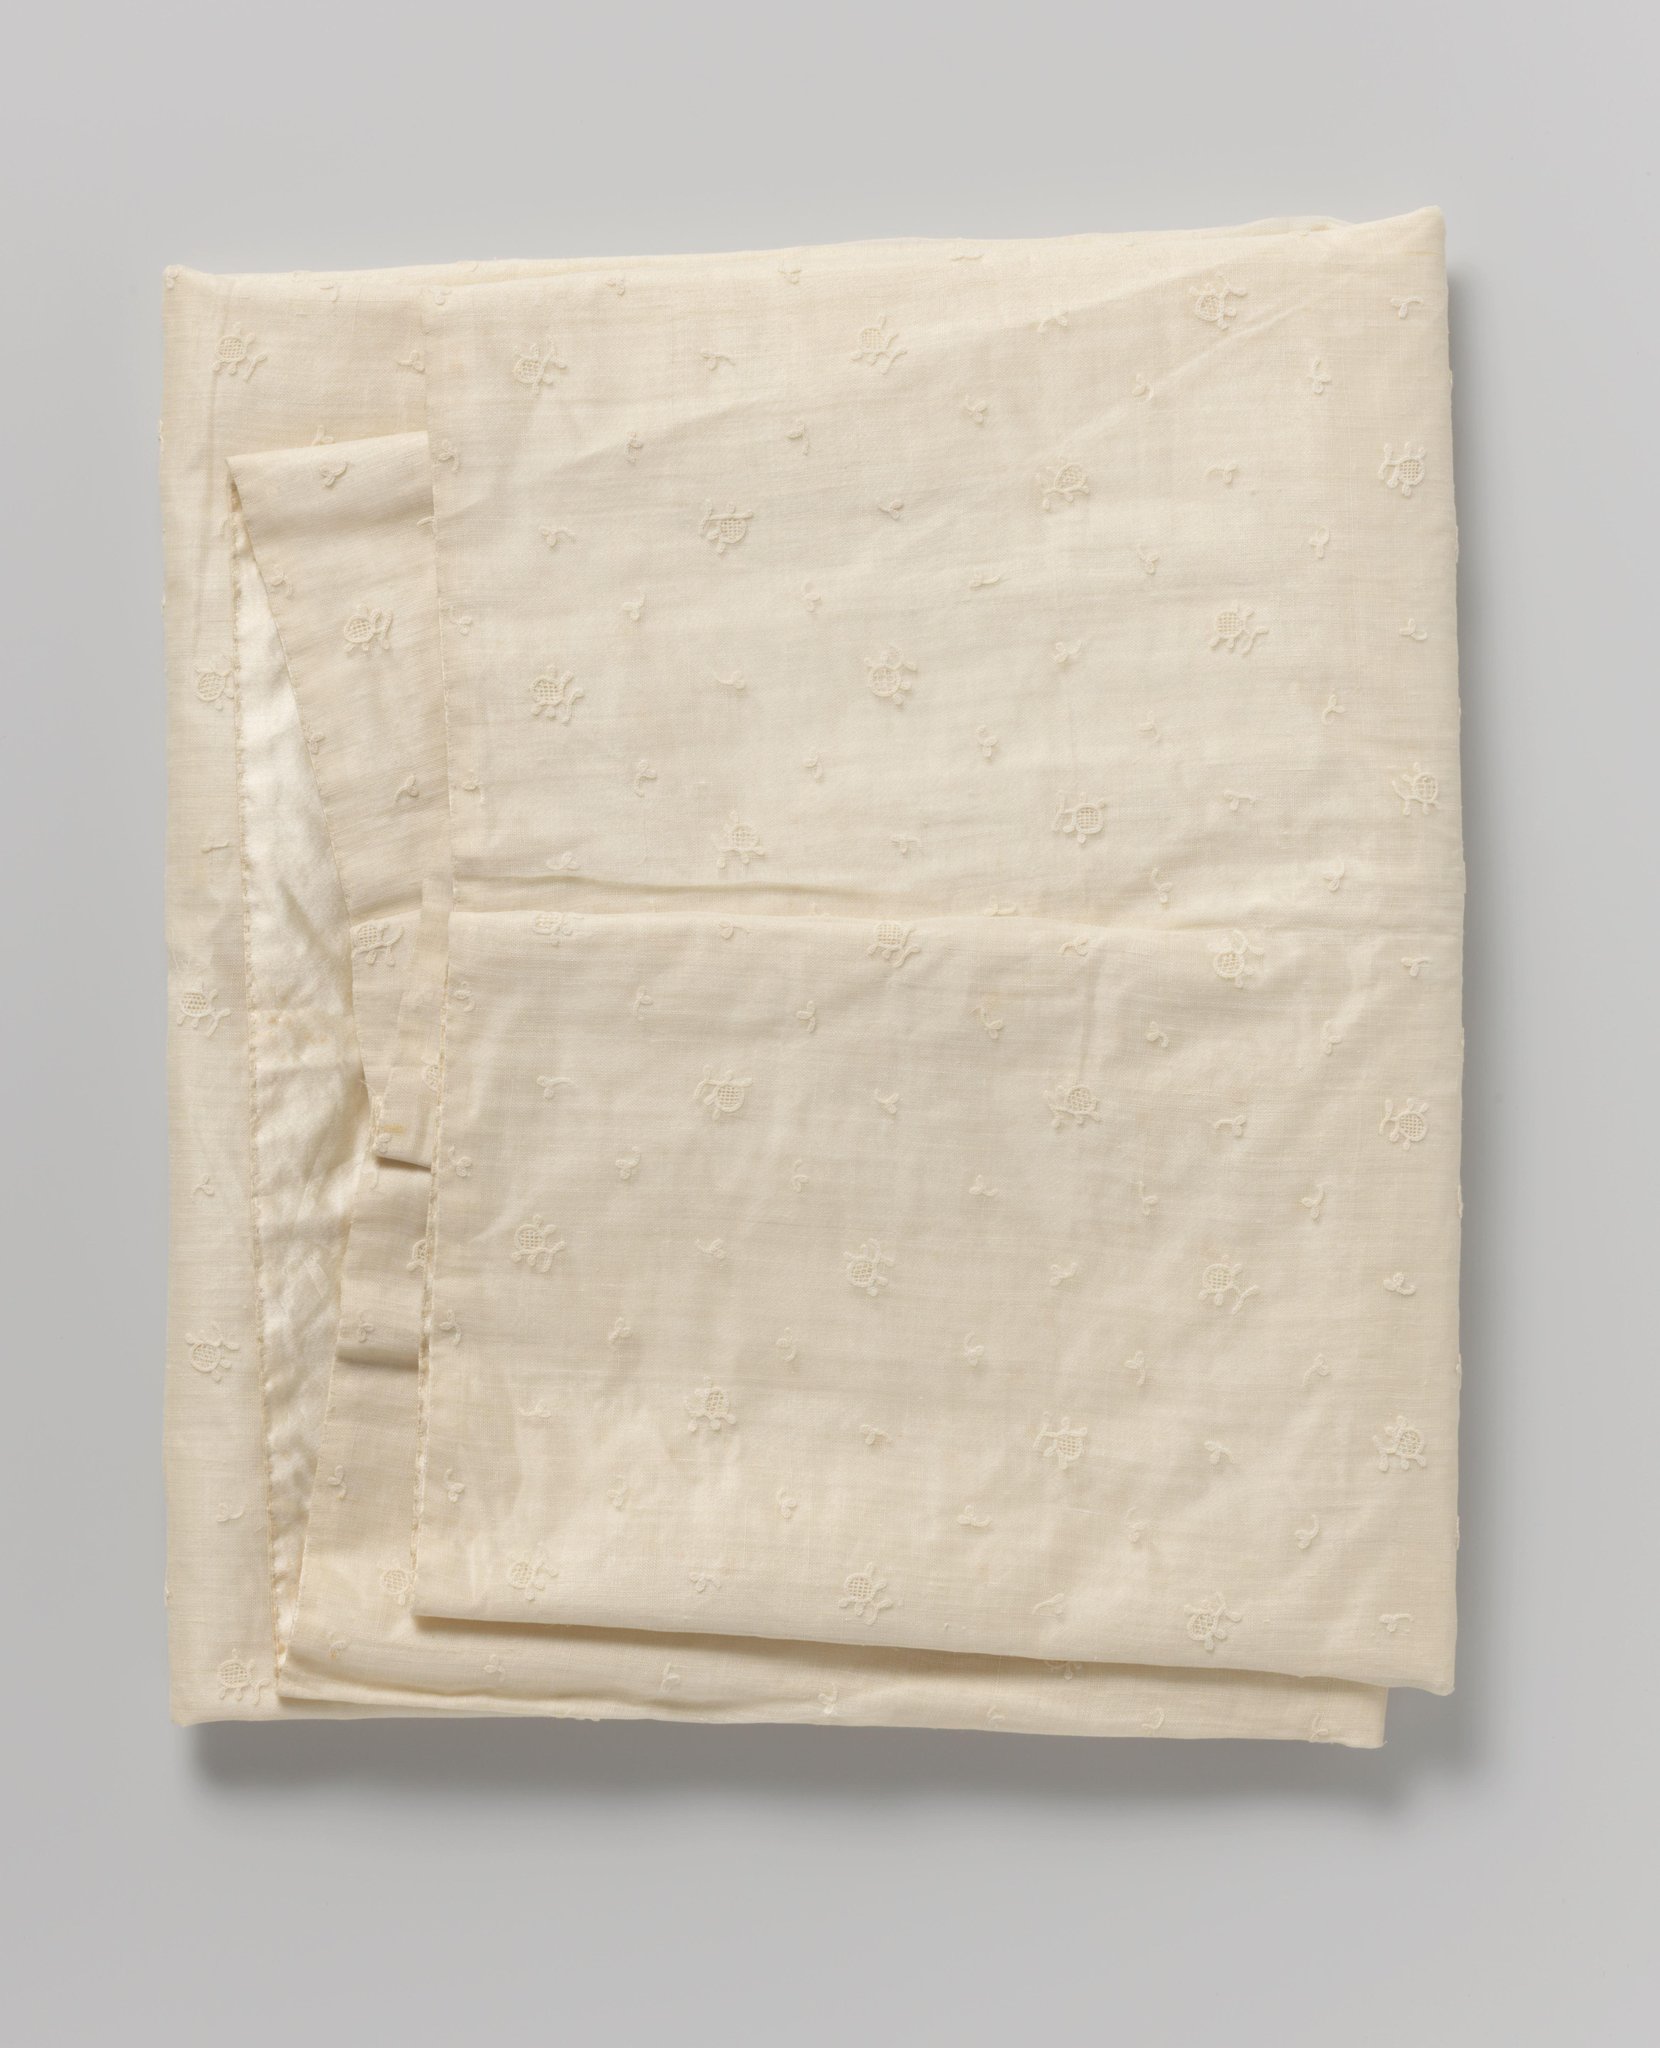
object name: baby wear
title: Babydraagkleed van wit linnen batist met wit tamboereerwerk op wit satijn, met strooipatroon van bessen en komma's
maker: Anonymous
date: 1775-1790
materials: textile, linen, silk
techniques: satin binding, tambouring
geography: netherlands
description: Babydraagkleed van wit linnen batist met wit tamboureerwerk opwit satijn, met strooipatroon van besjes en kommatjes.